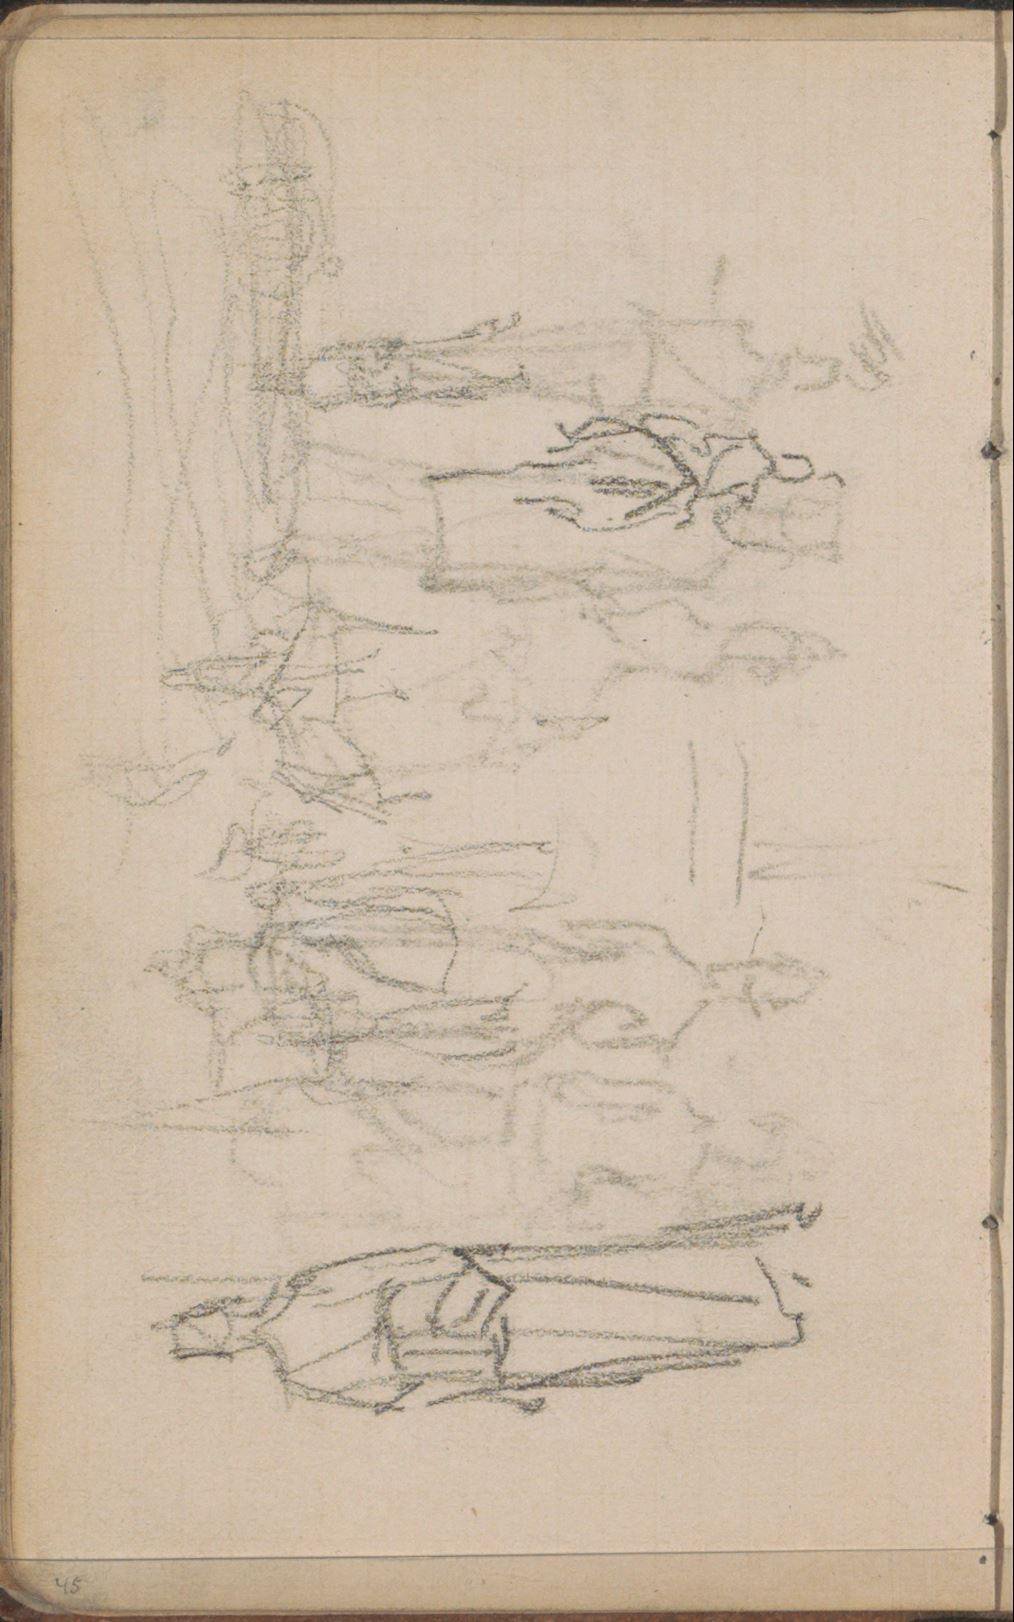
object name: sketchbook leaf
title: Figuurstudie en ruiters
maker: marius bauer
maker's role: draughtsman, print maker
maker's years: 1867-1932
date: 1879-1885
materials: chalk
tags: riding a horse, ass, or mule; rider, horseman, standing figure, (military) uniforms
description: De figuren dragen militair kostuum. Pagina 45 uit een schetsboek met 58 bladen.